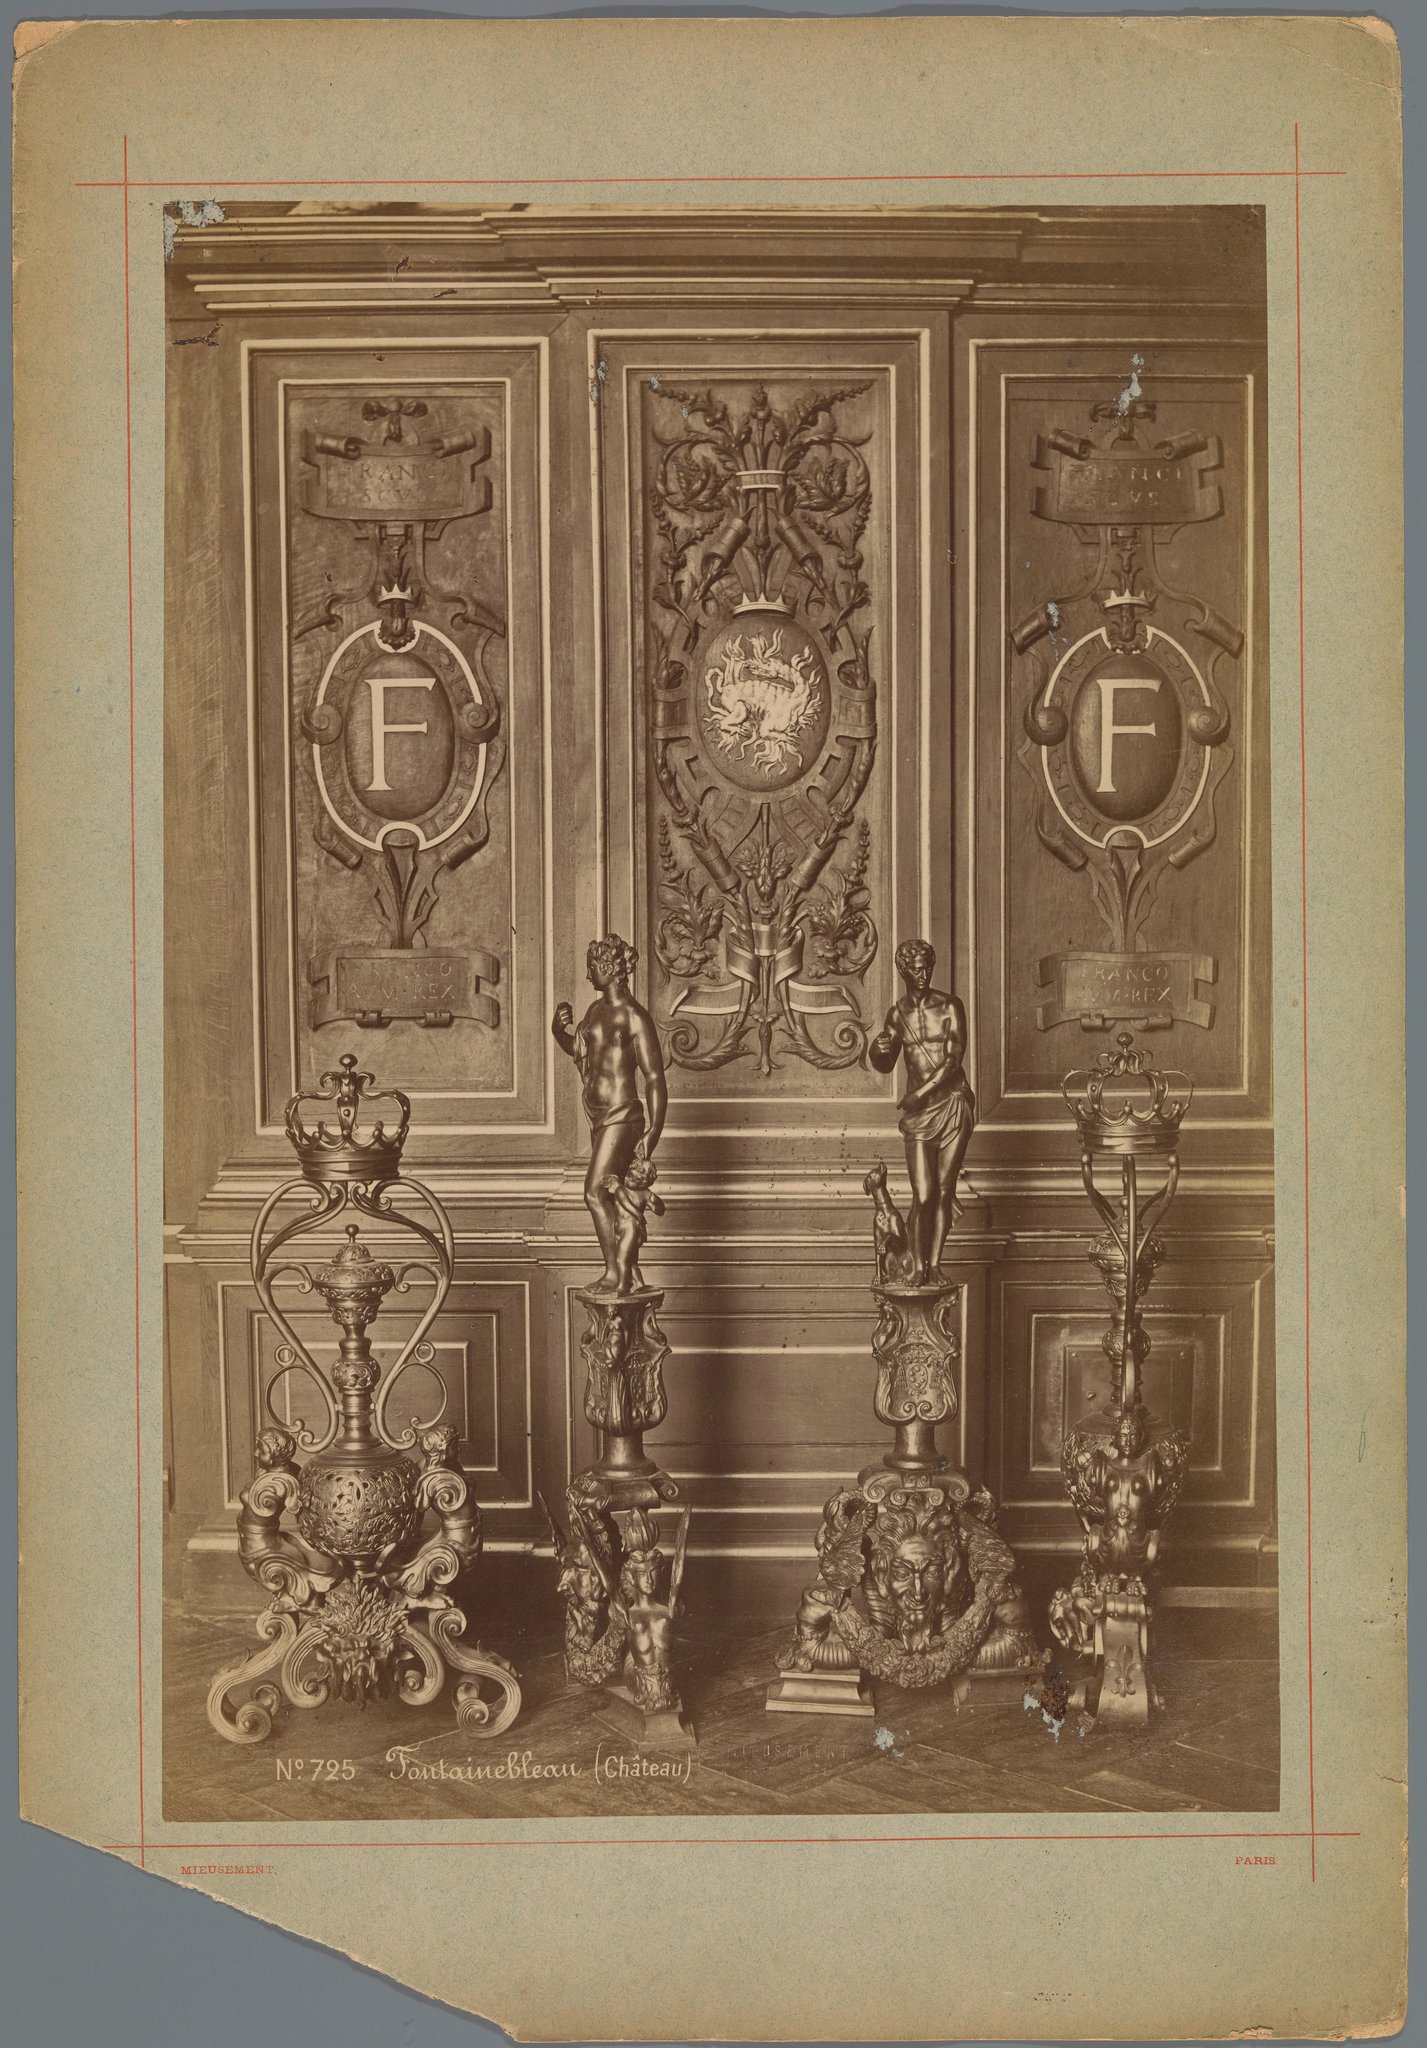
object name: photograph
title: Opstelling van vier smeedijzeren sculpturen voor een gedecoreerde wand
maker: séraphin-médéric mieusement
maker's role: fotograaf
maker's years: 1840-1905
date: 1875-1900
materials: cardboard, photographic support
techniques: albumen print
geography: fontainebleau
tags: palace, sculpture, interior ~ representation of a building, sculpture (+ relief ~ sculpture)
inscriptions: name: ‘MIEUSEMENT. PARIS.’, name: ‘Monsters worden door de Representant J. A. G. de Leur den Haag op franco aanvrage verzonden’, number: ‘No. 725’, name: ‘MIEUSEMENT PHOTOGRAPHE’, inscription: ‘MONUMENTS HISTORIQUES’, collector's mark: Lugt 3937